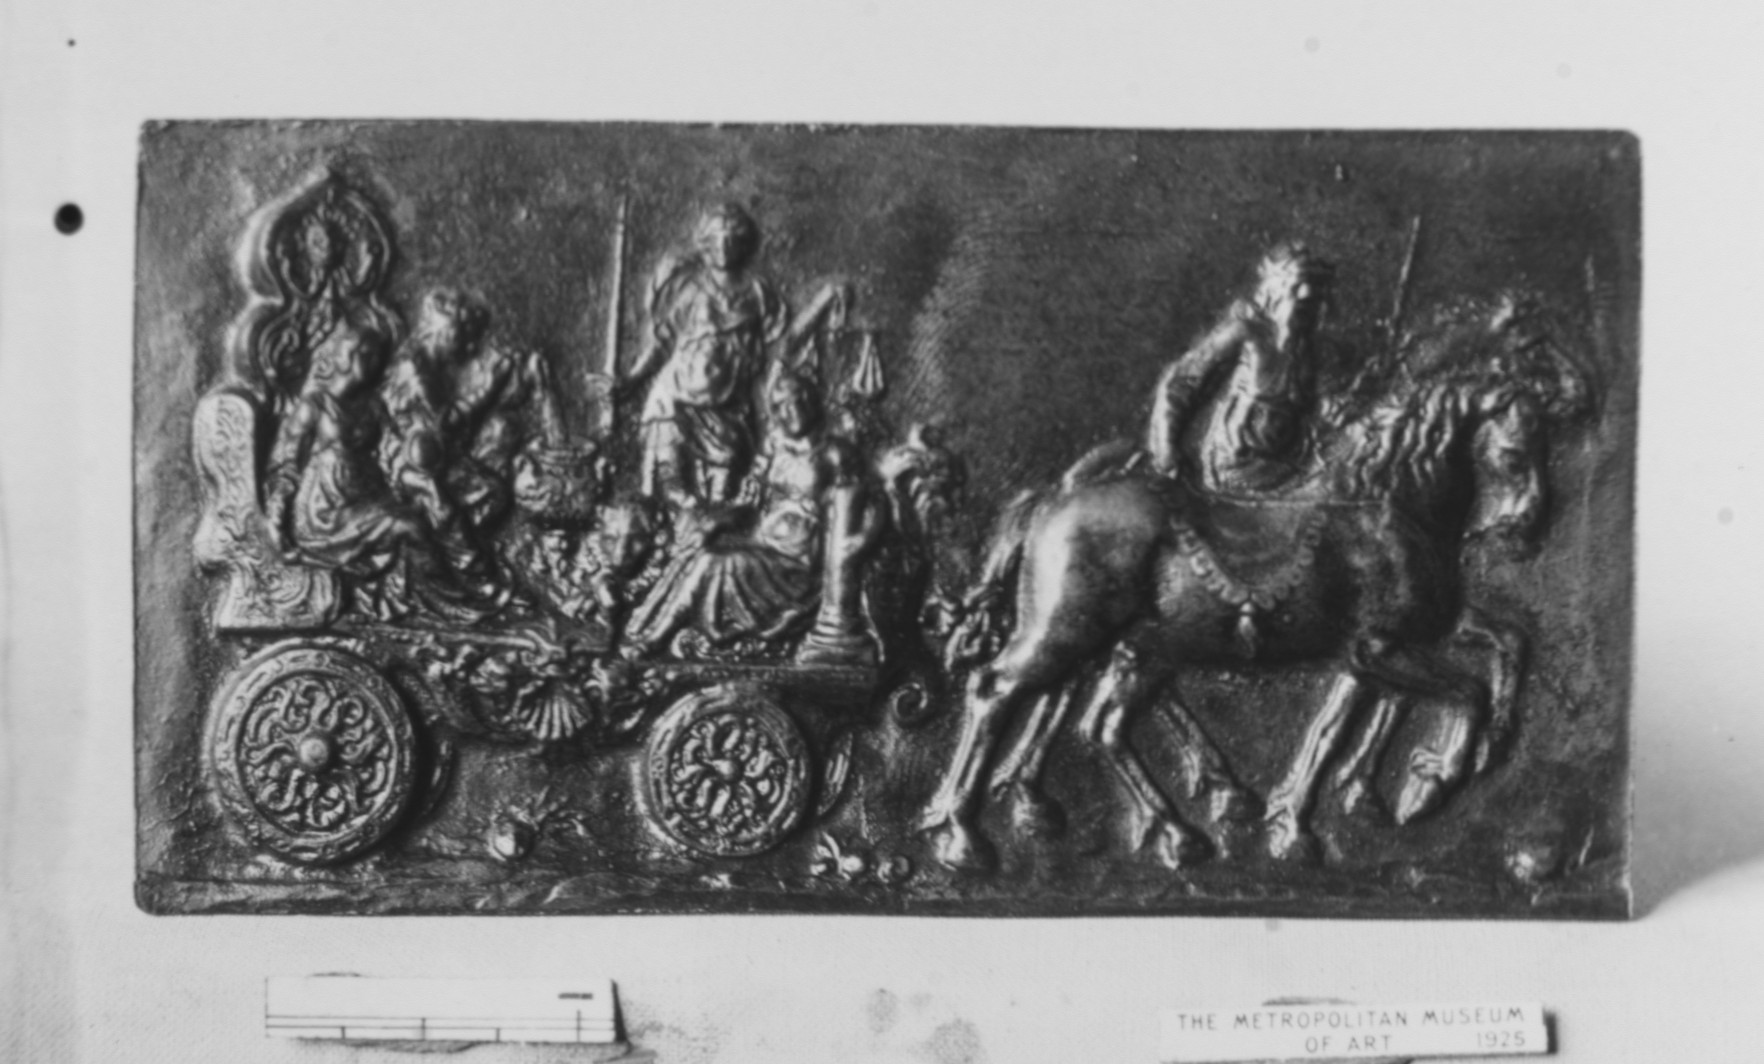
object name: plaquette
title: The Triumph of the Cardinal Virtues: Temperance, Prudence, Fortitude and Justice (one of a series)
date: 1576-1600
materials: bronze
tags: men,women,horses,chariots